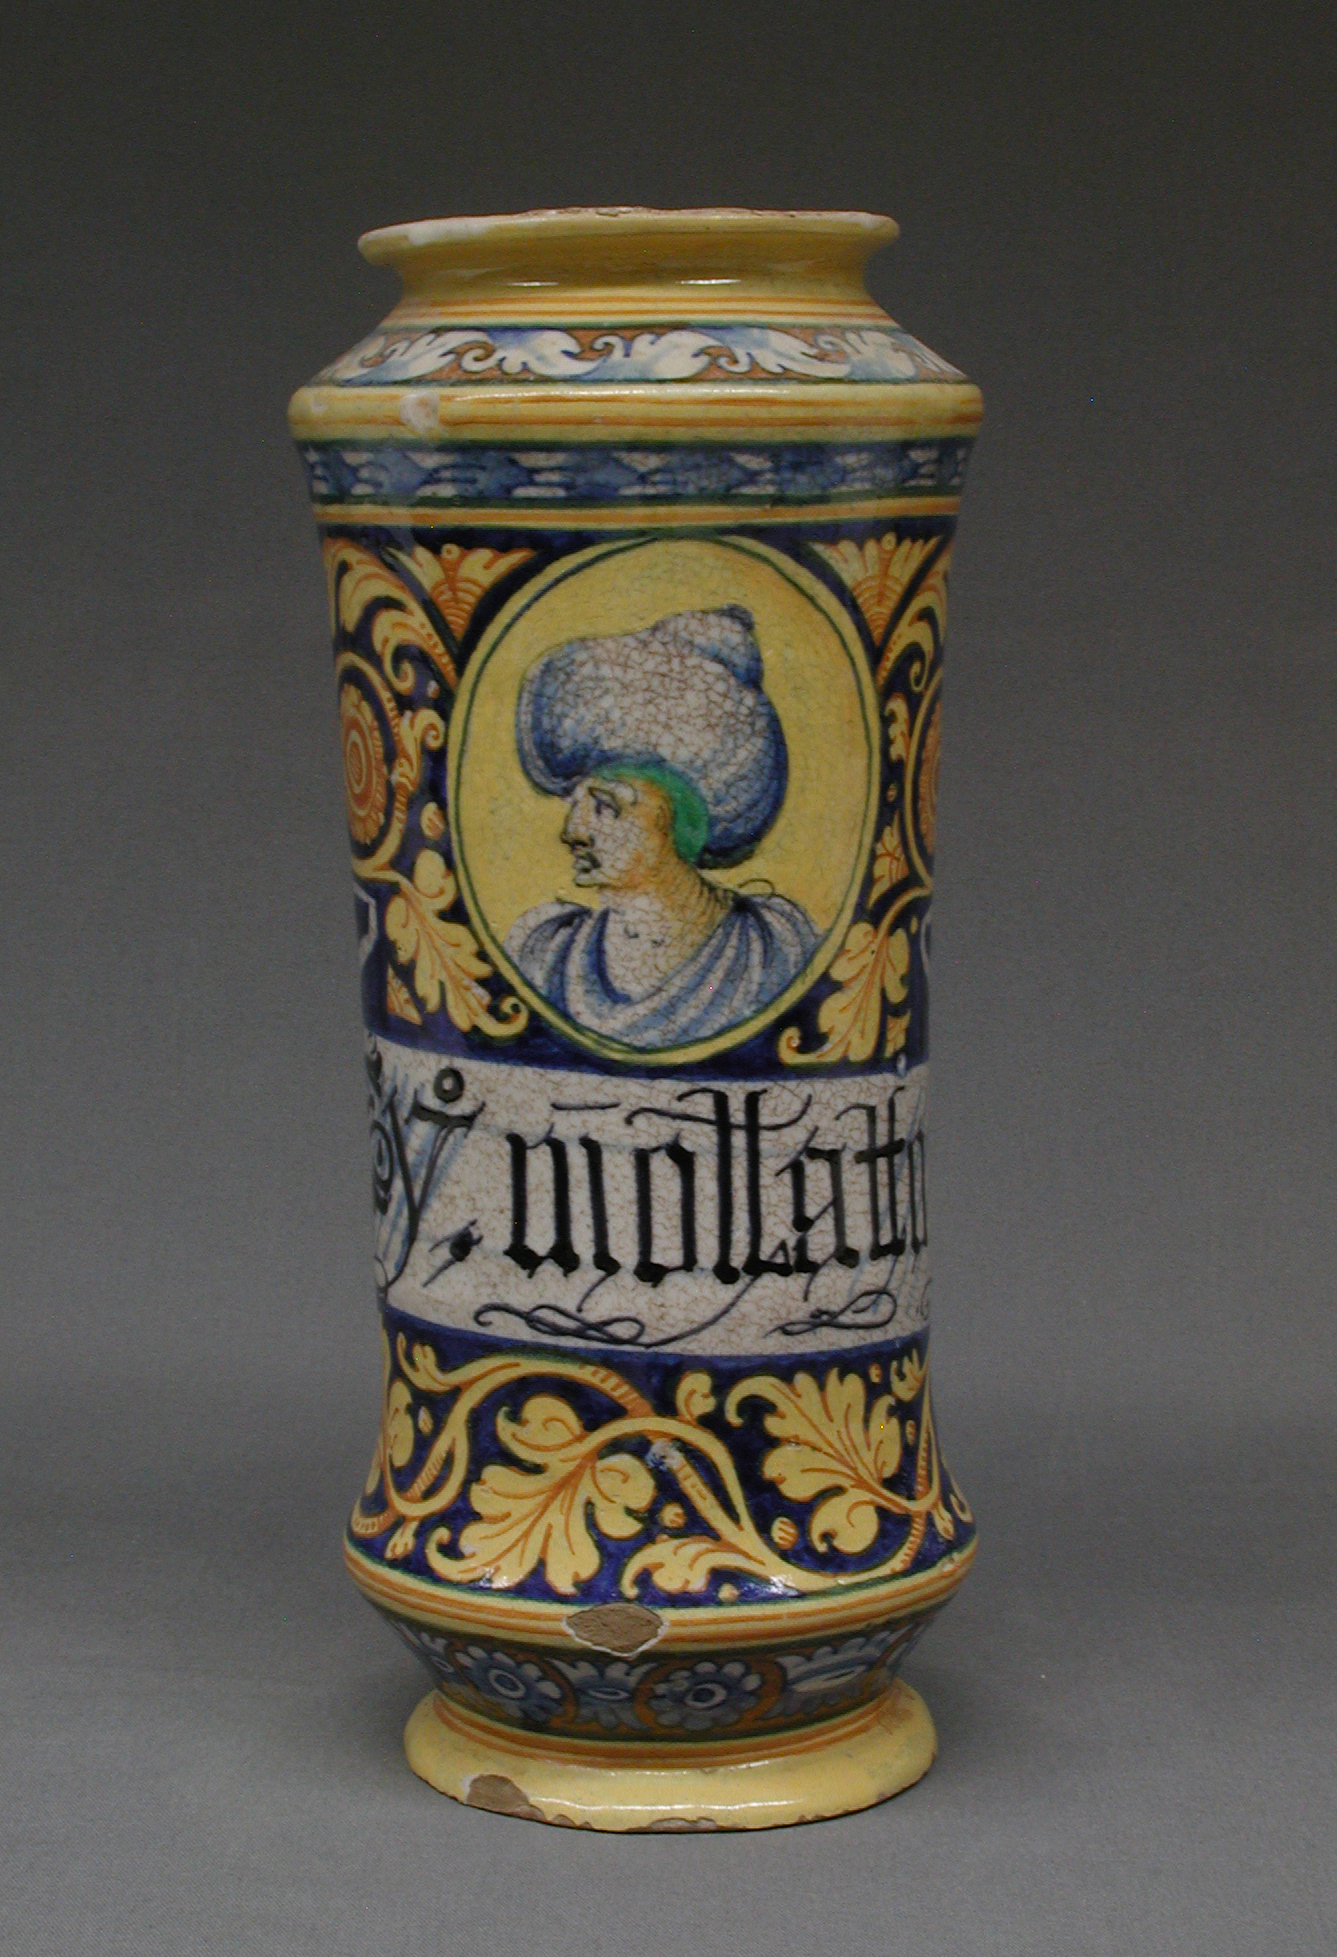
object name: albarello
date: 1501-1600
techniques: maiolica, glazing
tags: men,profiles